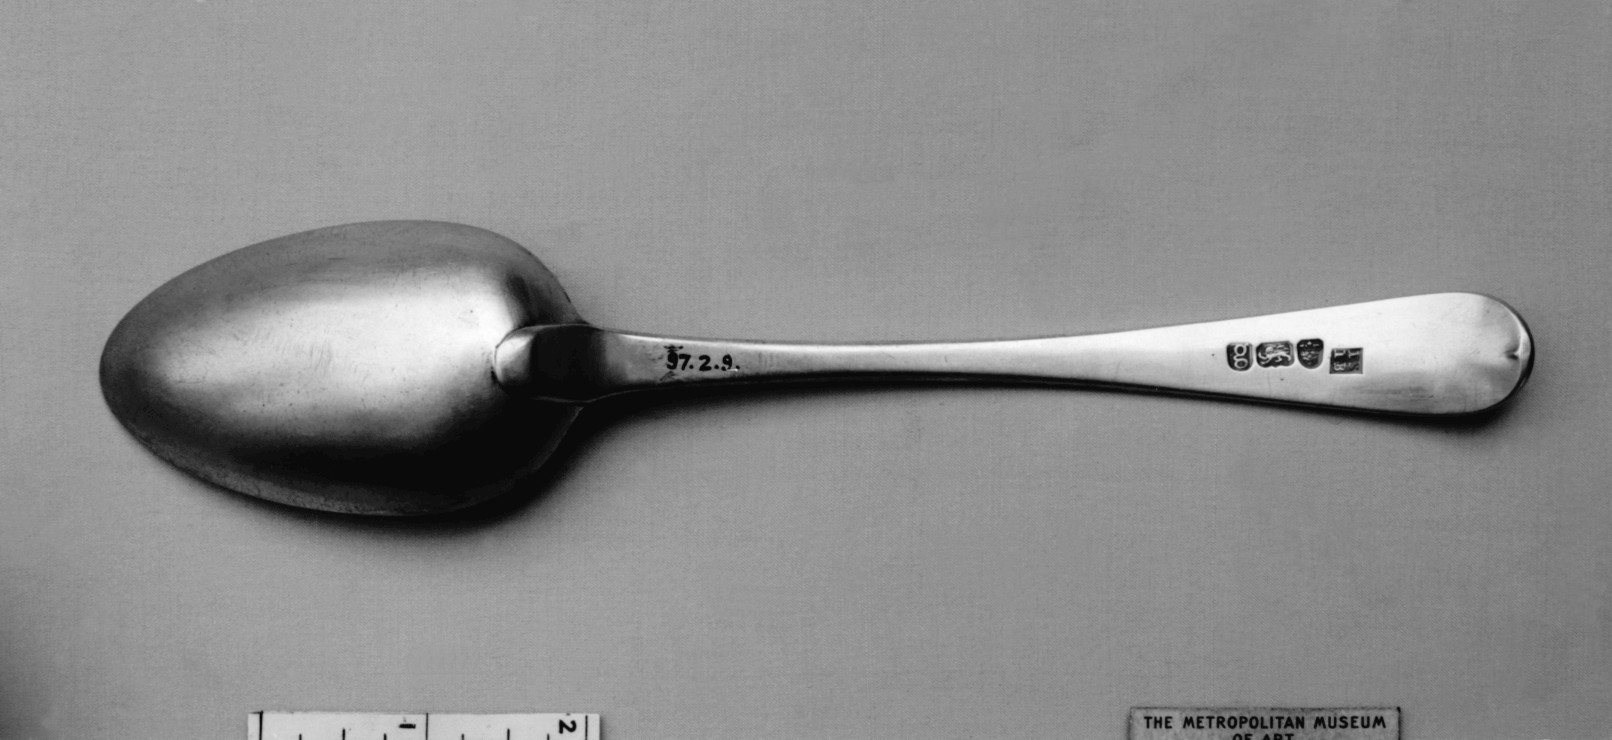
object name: tablespoon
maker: james sutton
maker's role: maker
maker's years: 1780-1793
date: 1782-1783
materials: silver